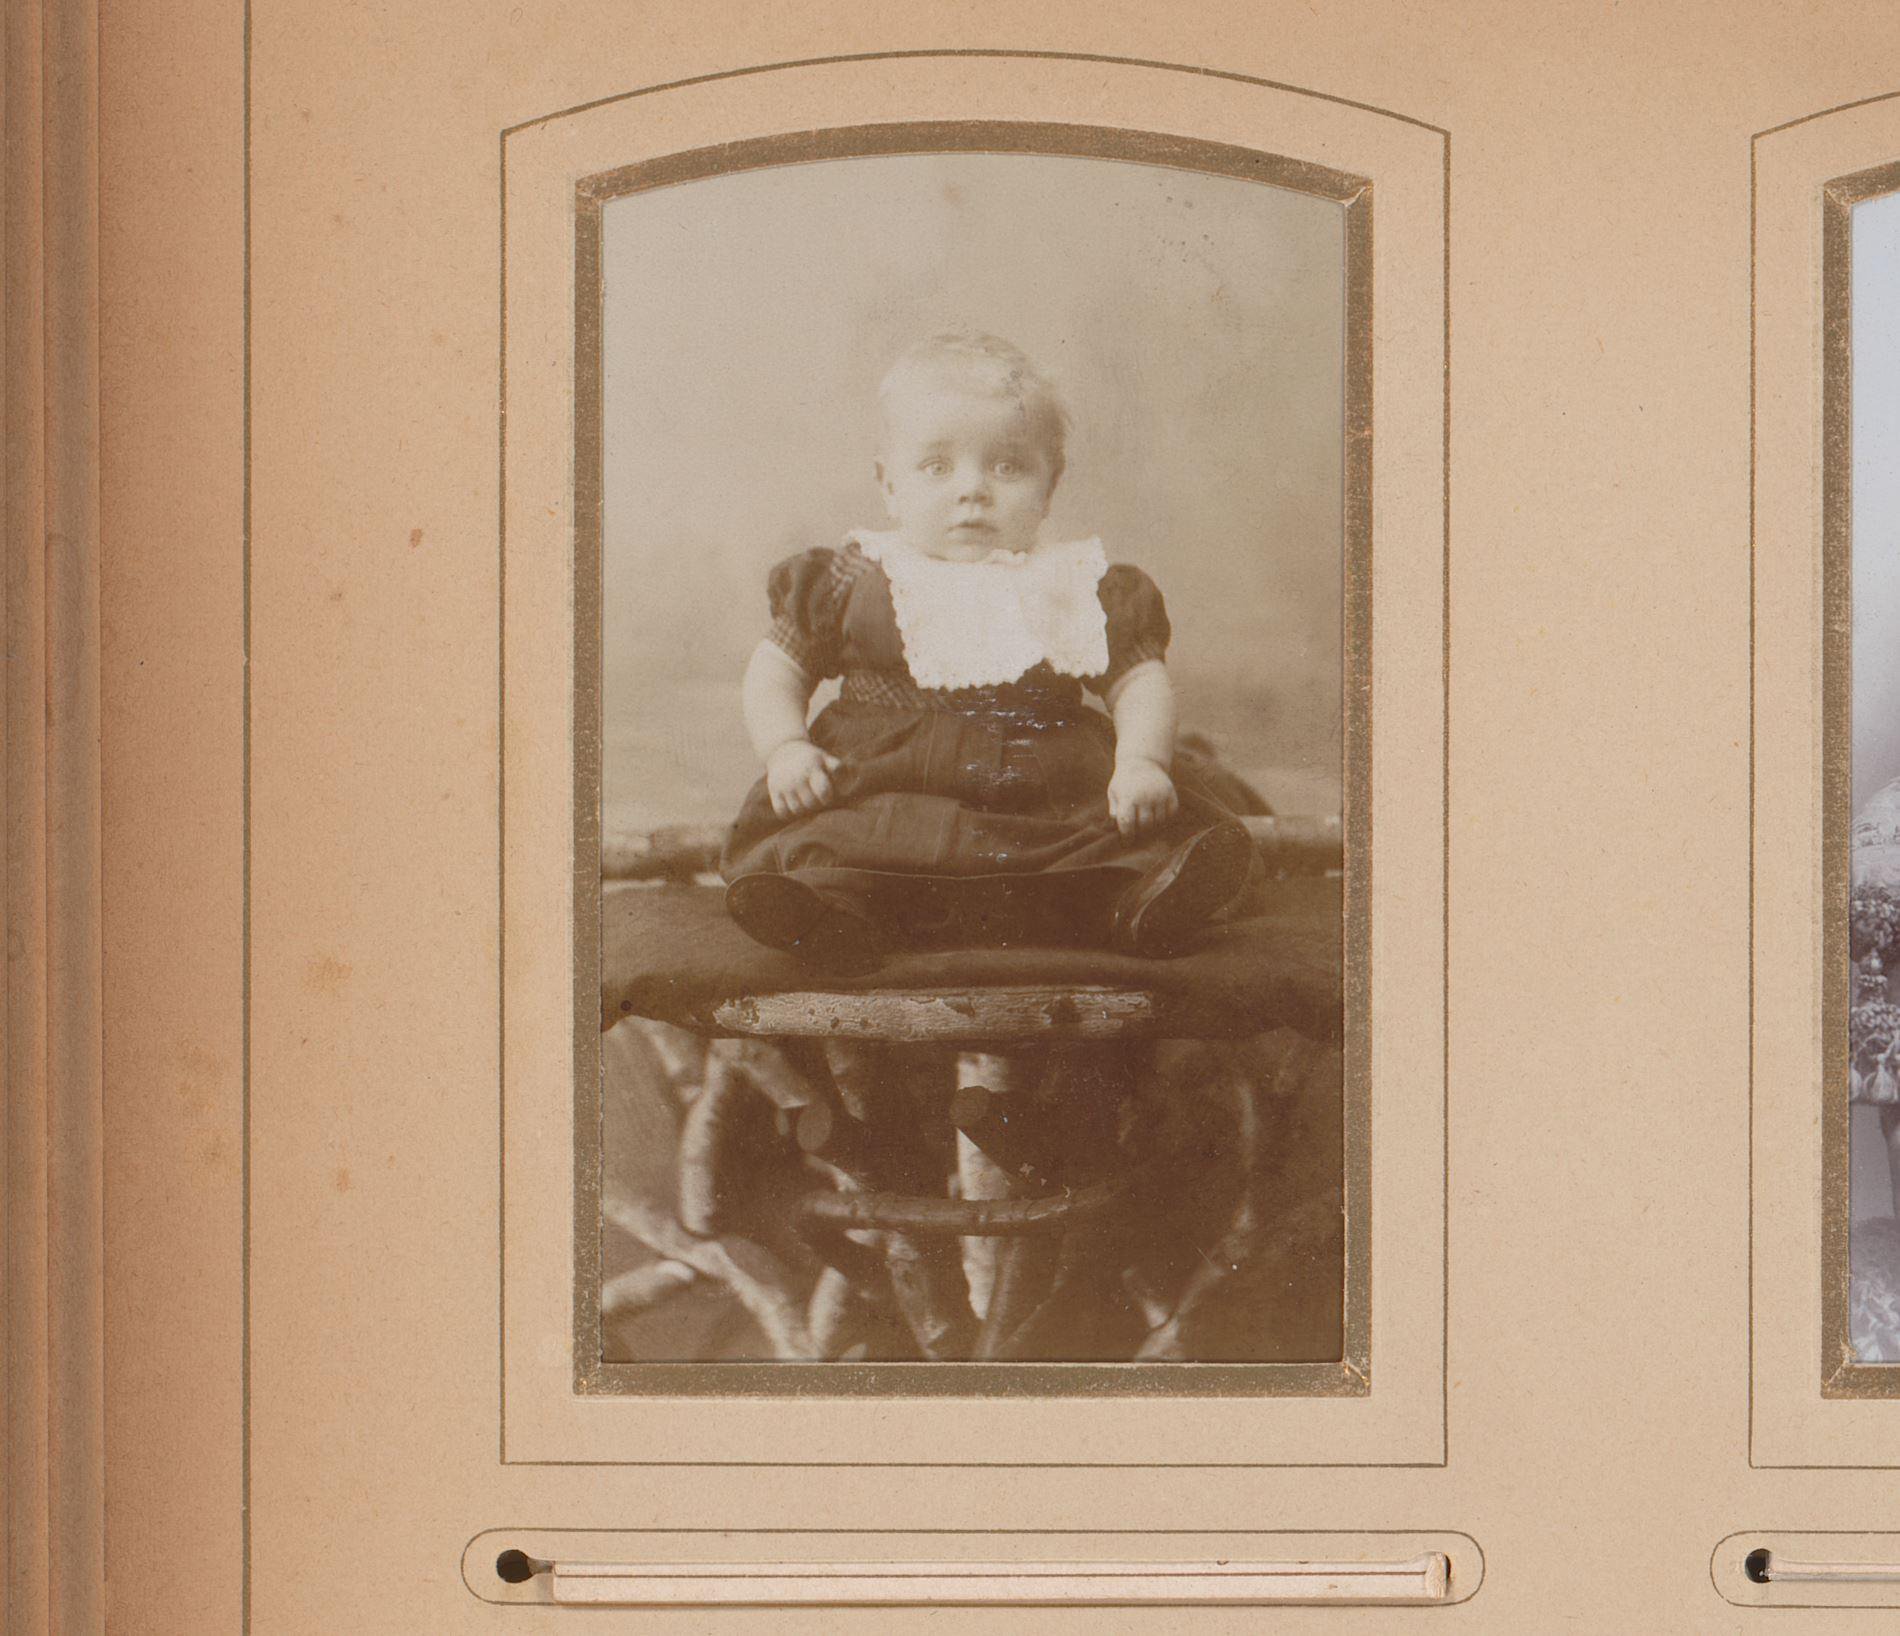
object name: photograph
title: Portret van een zittende baby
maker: sander van der zijl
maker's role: fotograaf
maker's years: 1852-1935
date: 1881-1907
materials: cardboard, photographic support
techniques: collodion silver print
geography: amsterdam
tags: sitting figure, historical persons, infant, baby ~ the ages of man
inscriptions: inscription: ‘Photographische/ Ateliers/ S. van der Zijl/ Amsterdam/ Nieuwendijk 199/ Heiligenweg/ 34./ 219, KALVERSTRAAT 219, b/d Munt.’